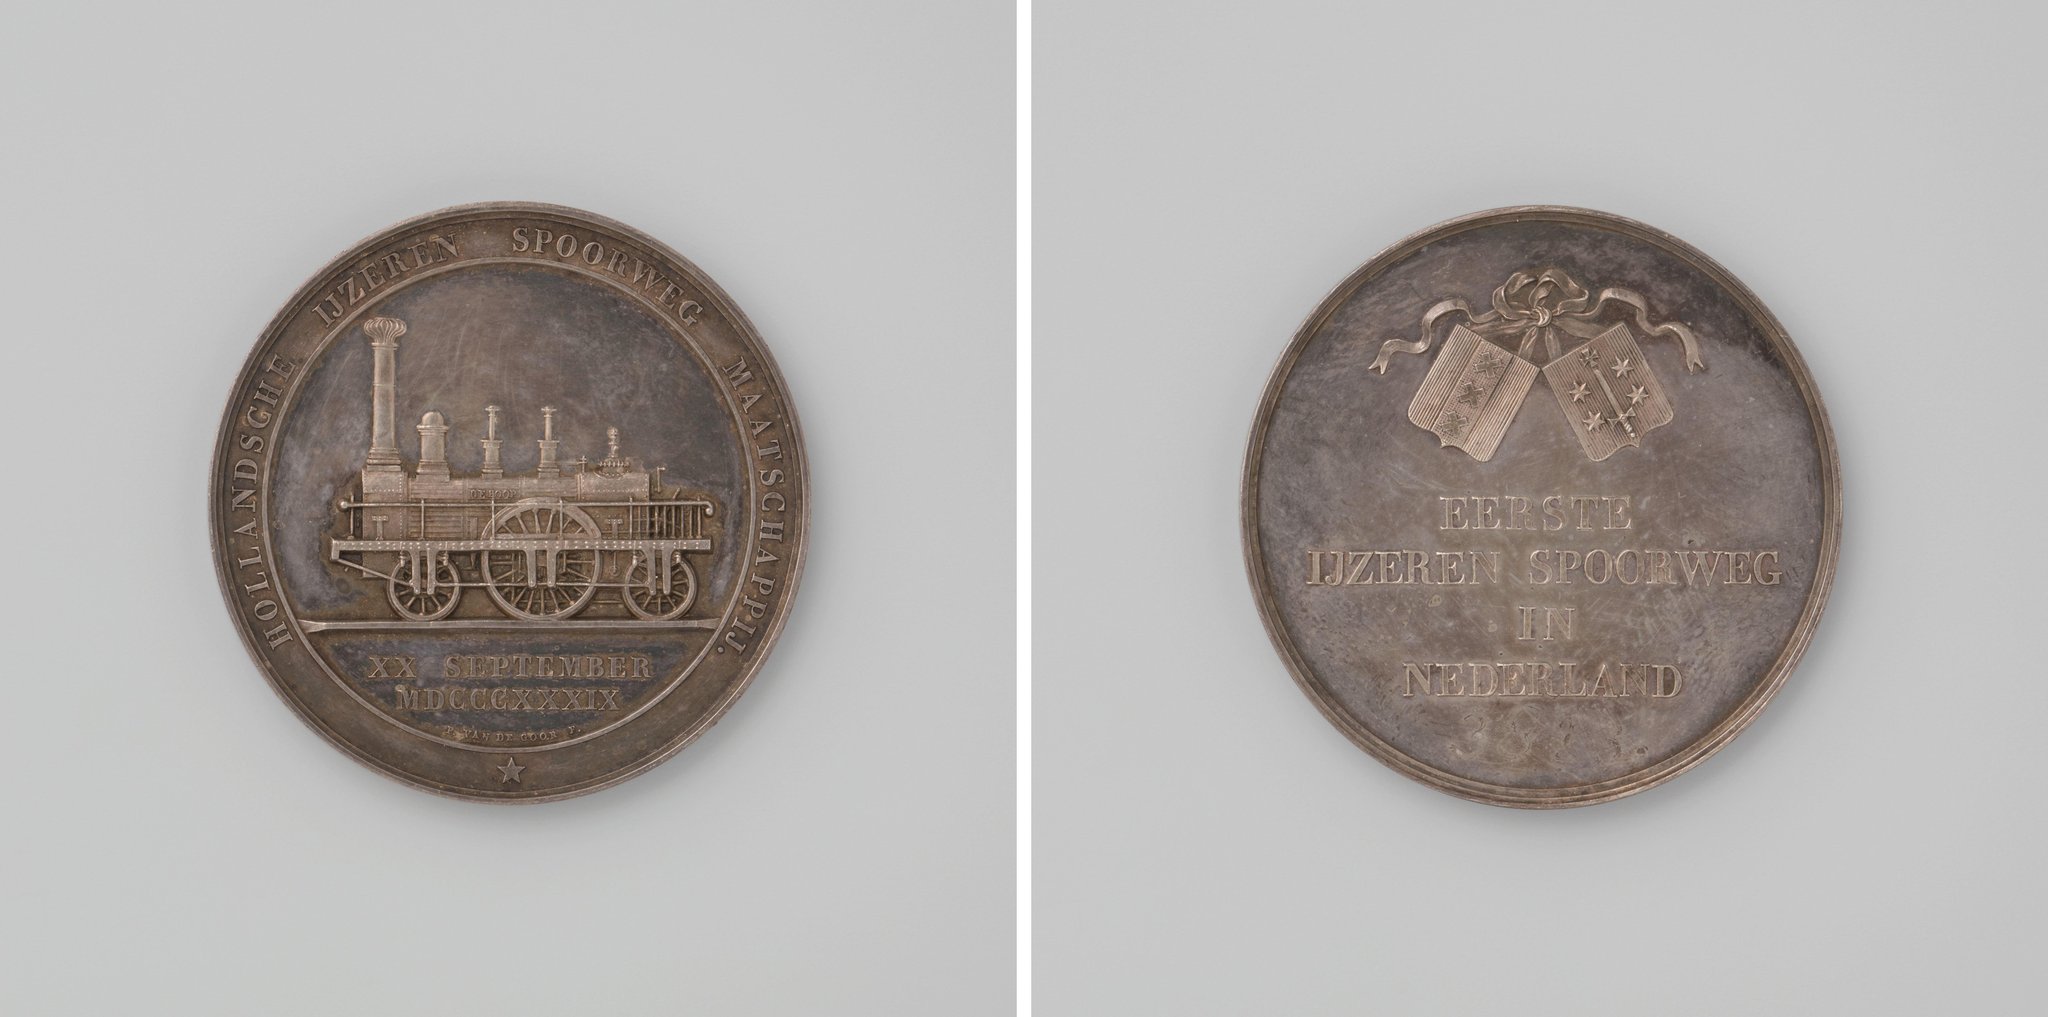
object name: history medal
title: Opening van de spoorweg Amsterdam-Haarlem, de eerste spoorlijn in Nederland van de Hollandsche IJzeren Spoorweg Maatschappij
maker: pierre wautier van de goor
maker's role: medailleur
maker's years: 1783-1851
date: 1839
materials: silver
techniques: striking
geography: utrecht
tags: haarlem, amsterdam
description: Zilveren penning. Voorzijde: stoomlocomotief "de Hoop" binnen omschrift; afsnede: datering en signatuur. Keerzijde: opschrift onder twee met strik samengebonden wapenschilden.